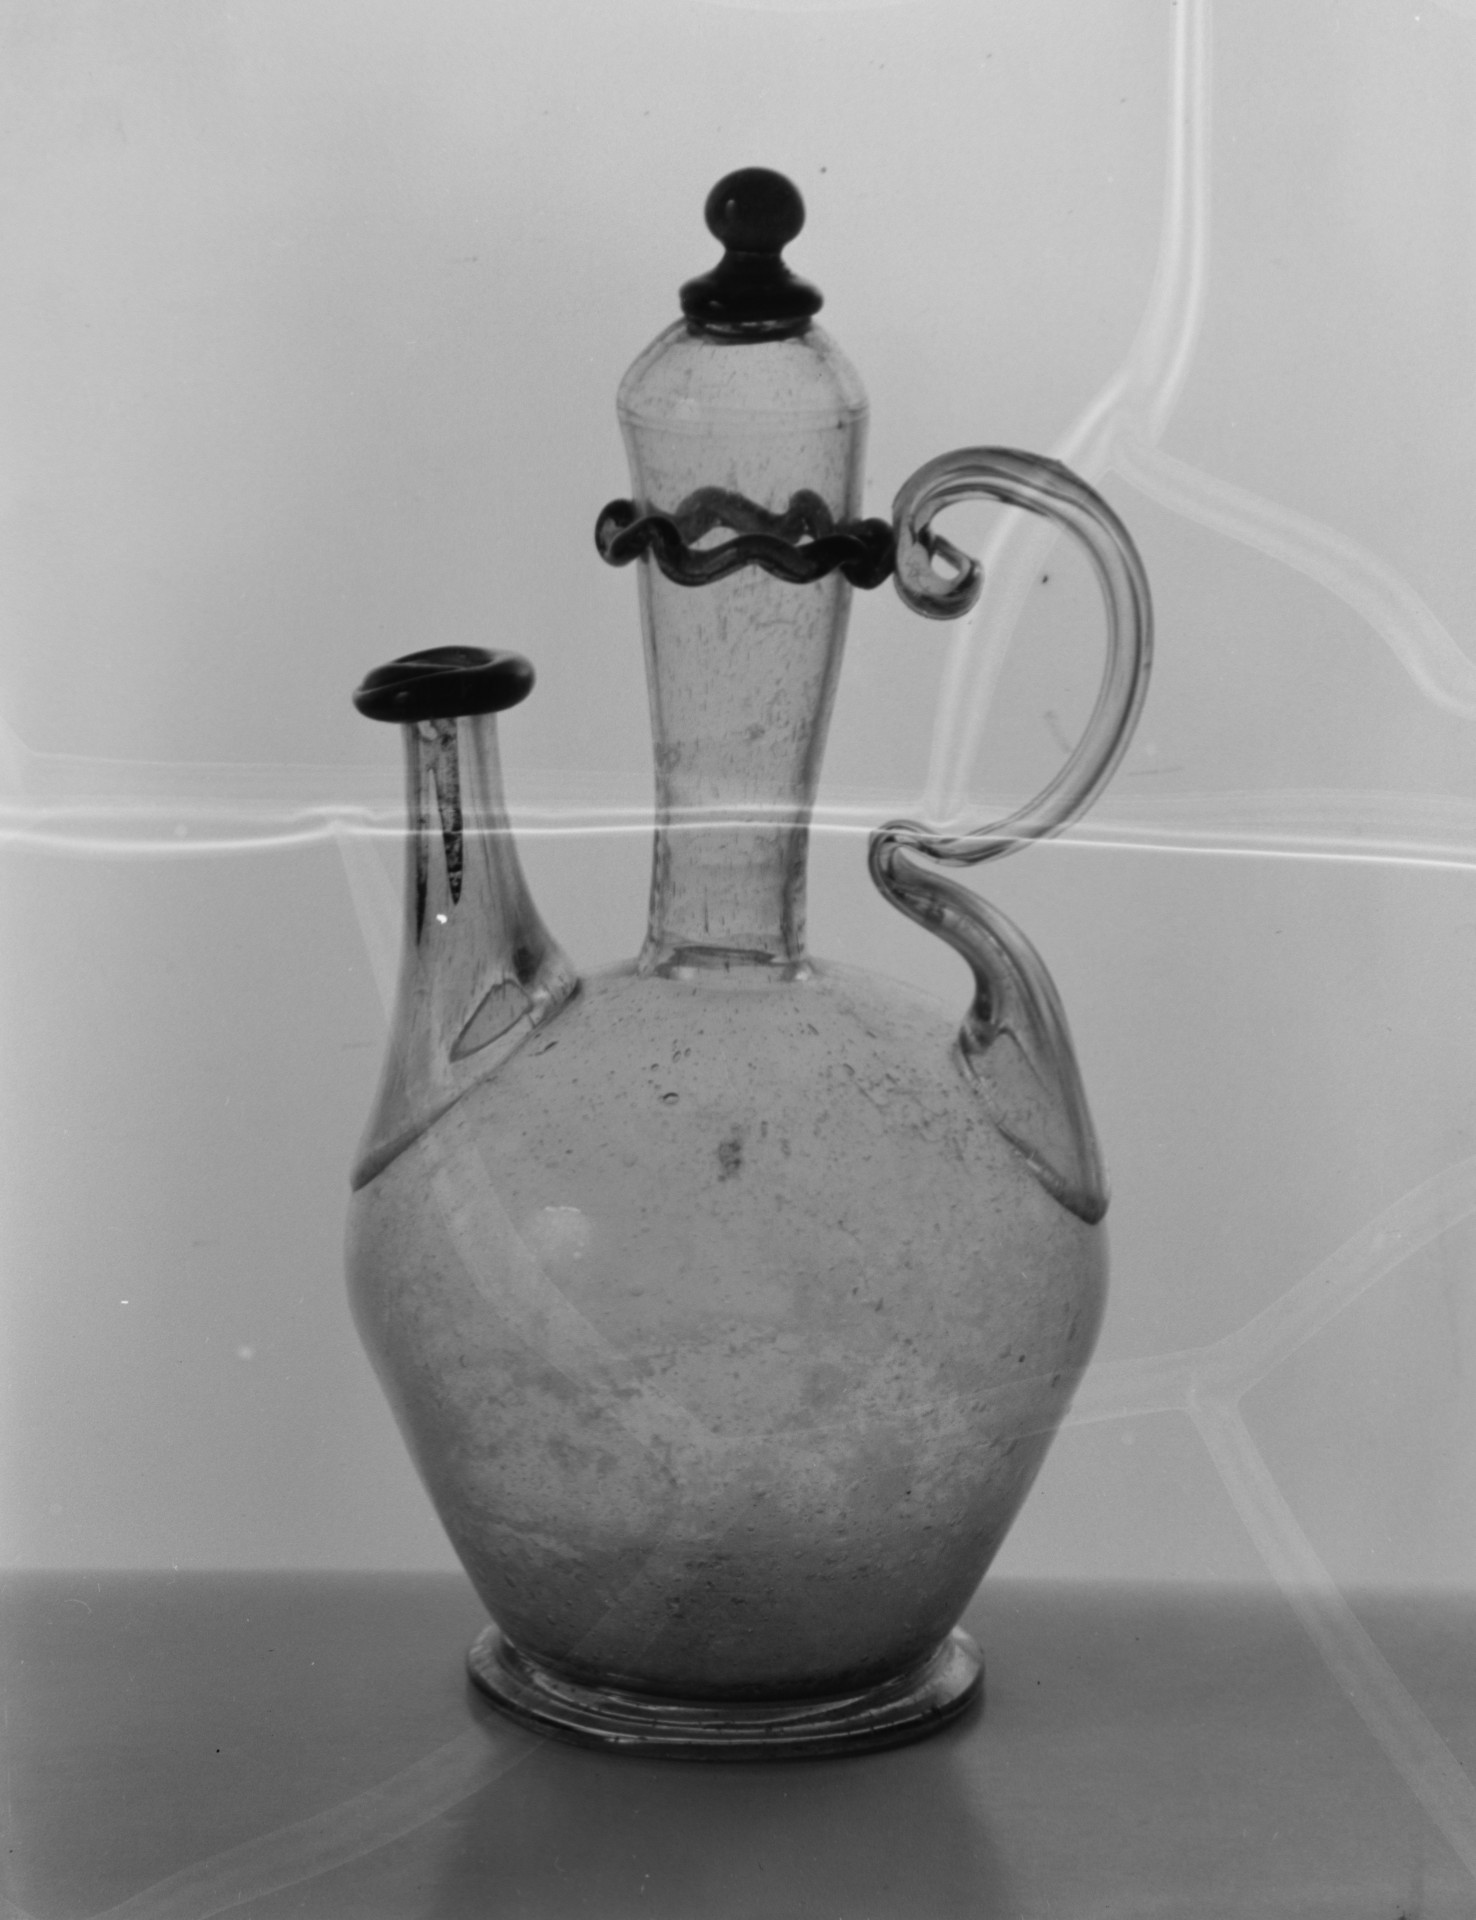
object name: biberon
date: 1601-1700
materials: glass